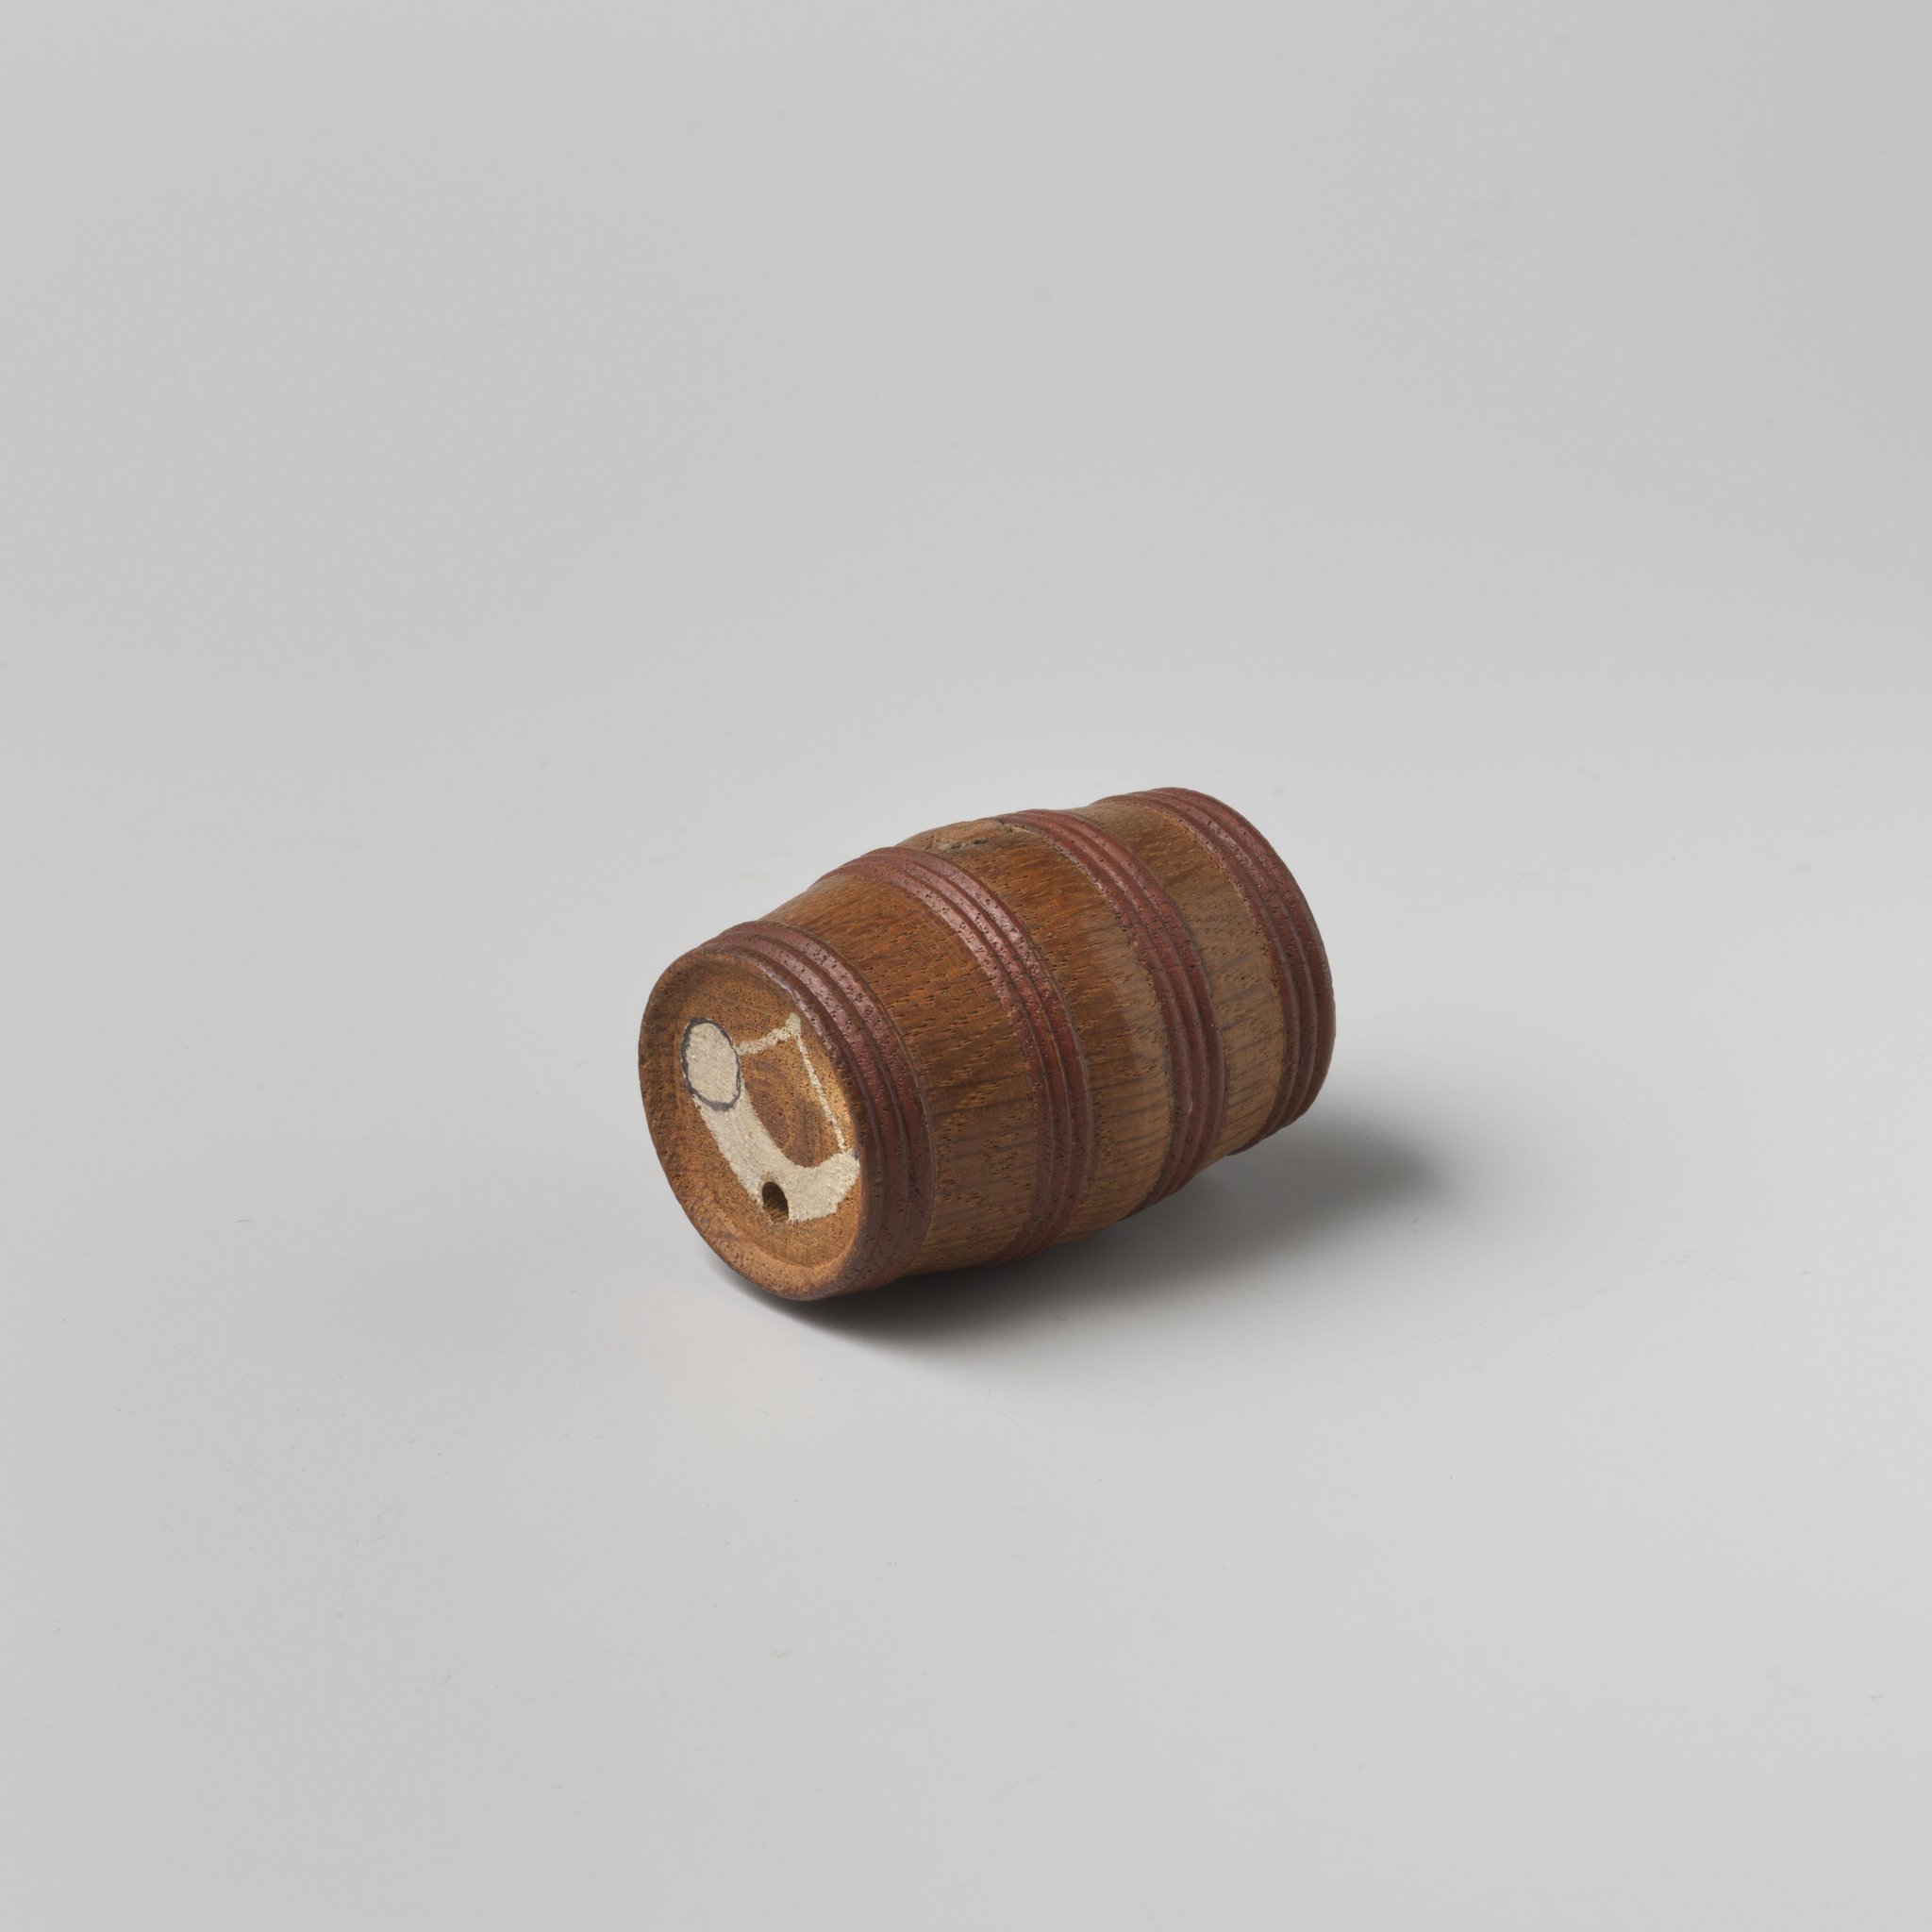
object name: vessel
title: Biervat van eikenhout, beschilderd met een hoorn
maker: Anonymous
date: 1676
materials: wood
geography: amsterdam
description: Biervat van eikenhout, gedraaid uit een massief blok hout, met ringen (hoepels voorstellende), een spongat met stop bovenop, en een gat voor een tapkraan in de voorzijde. Het voorbord van het vat is beschilderd met een hoorn.